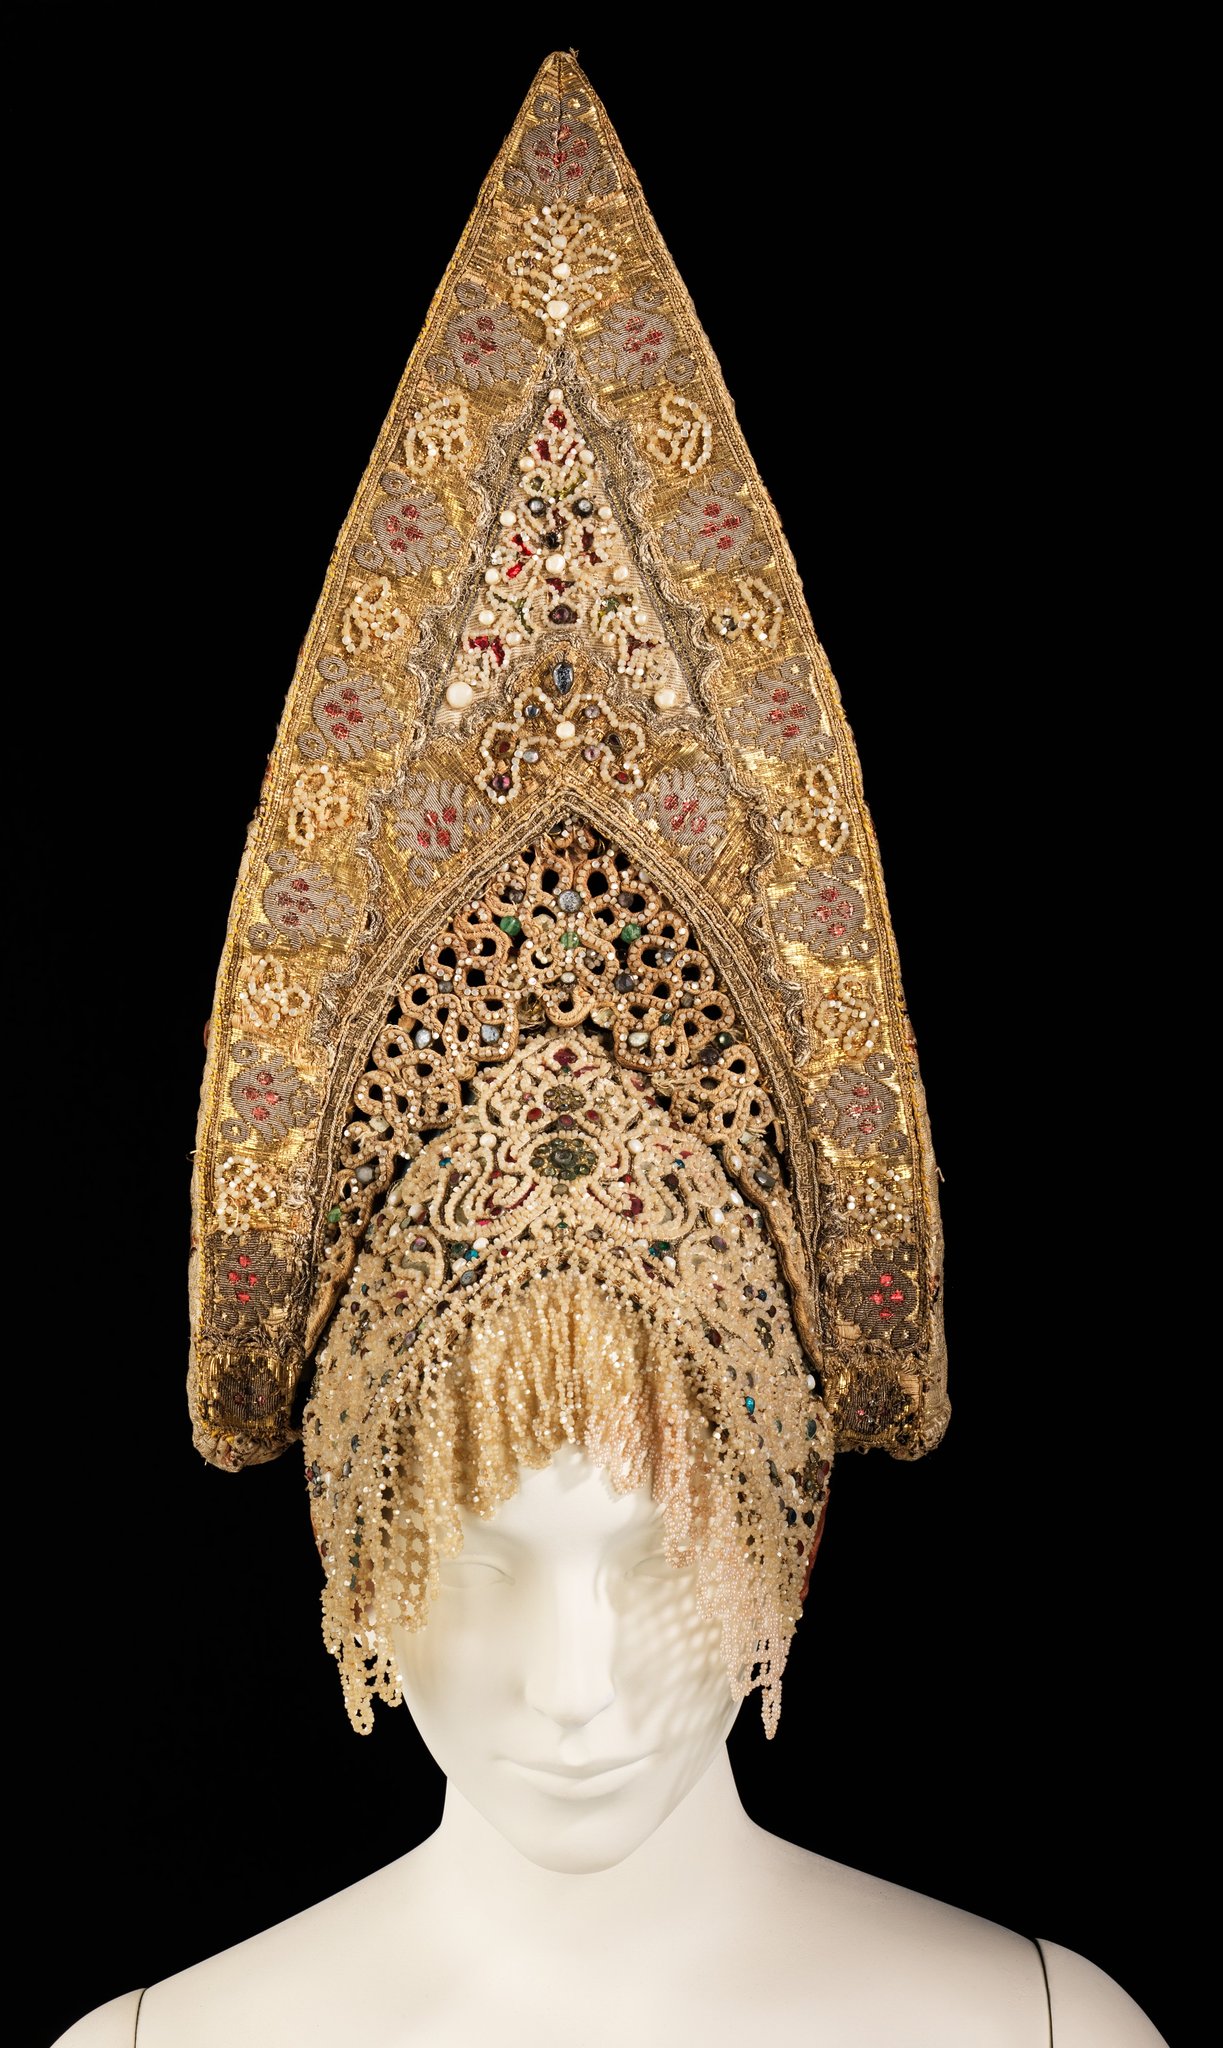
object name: headdress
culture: russian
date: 1801-1833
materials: cotton, metal, paper, pearl, silk